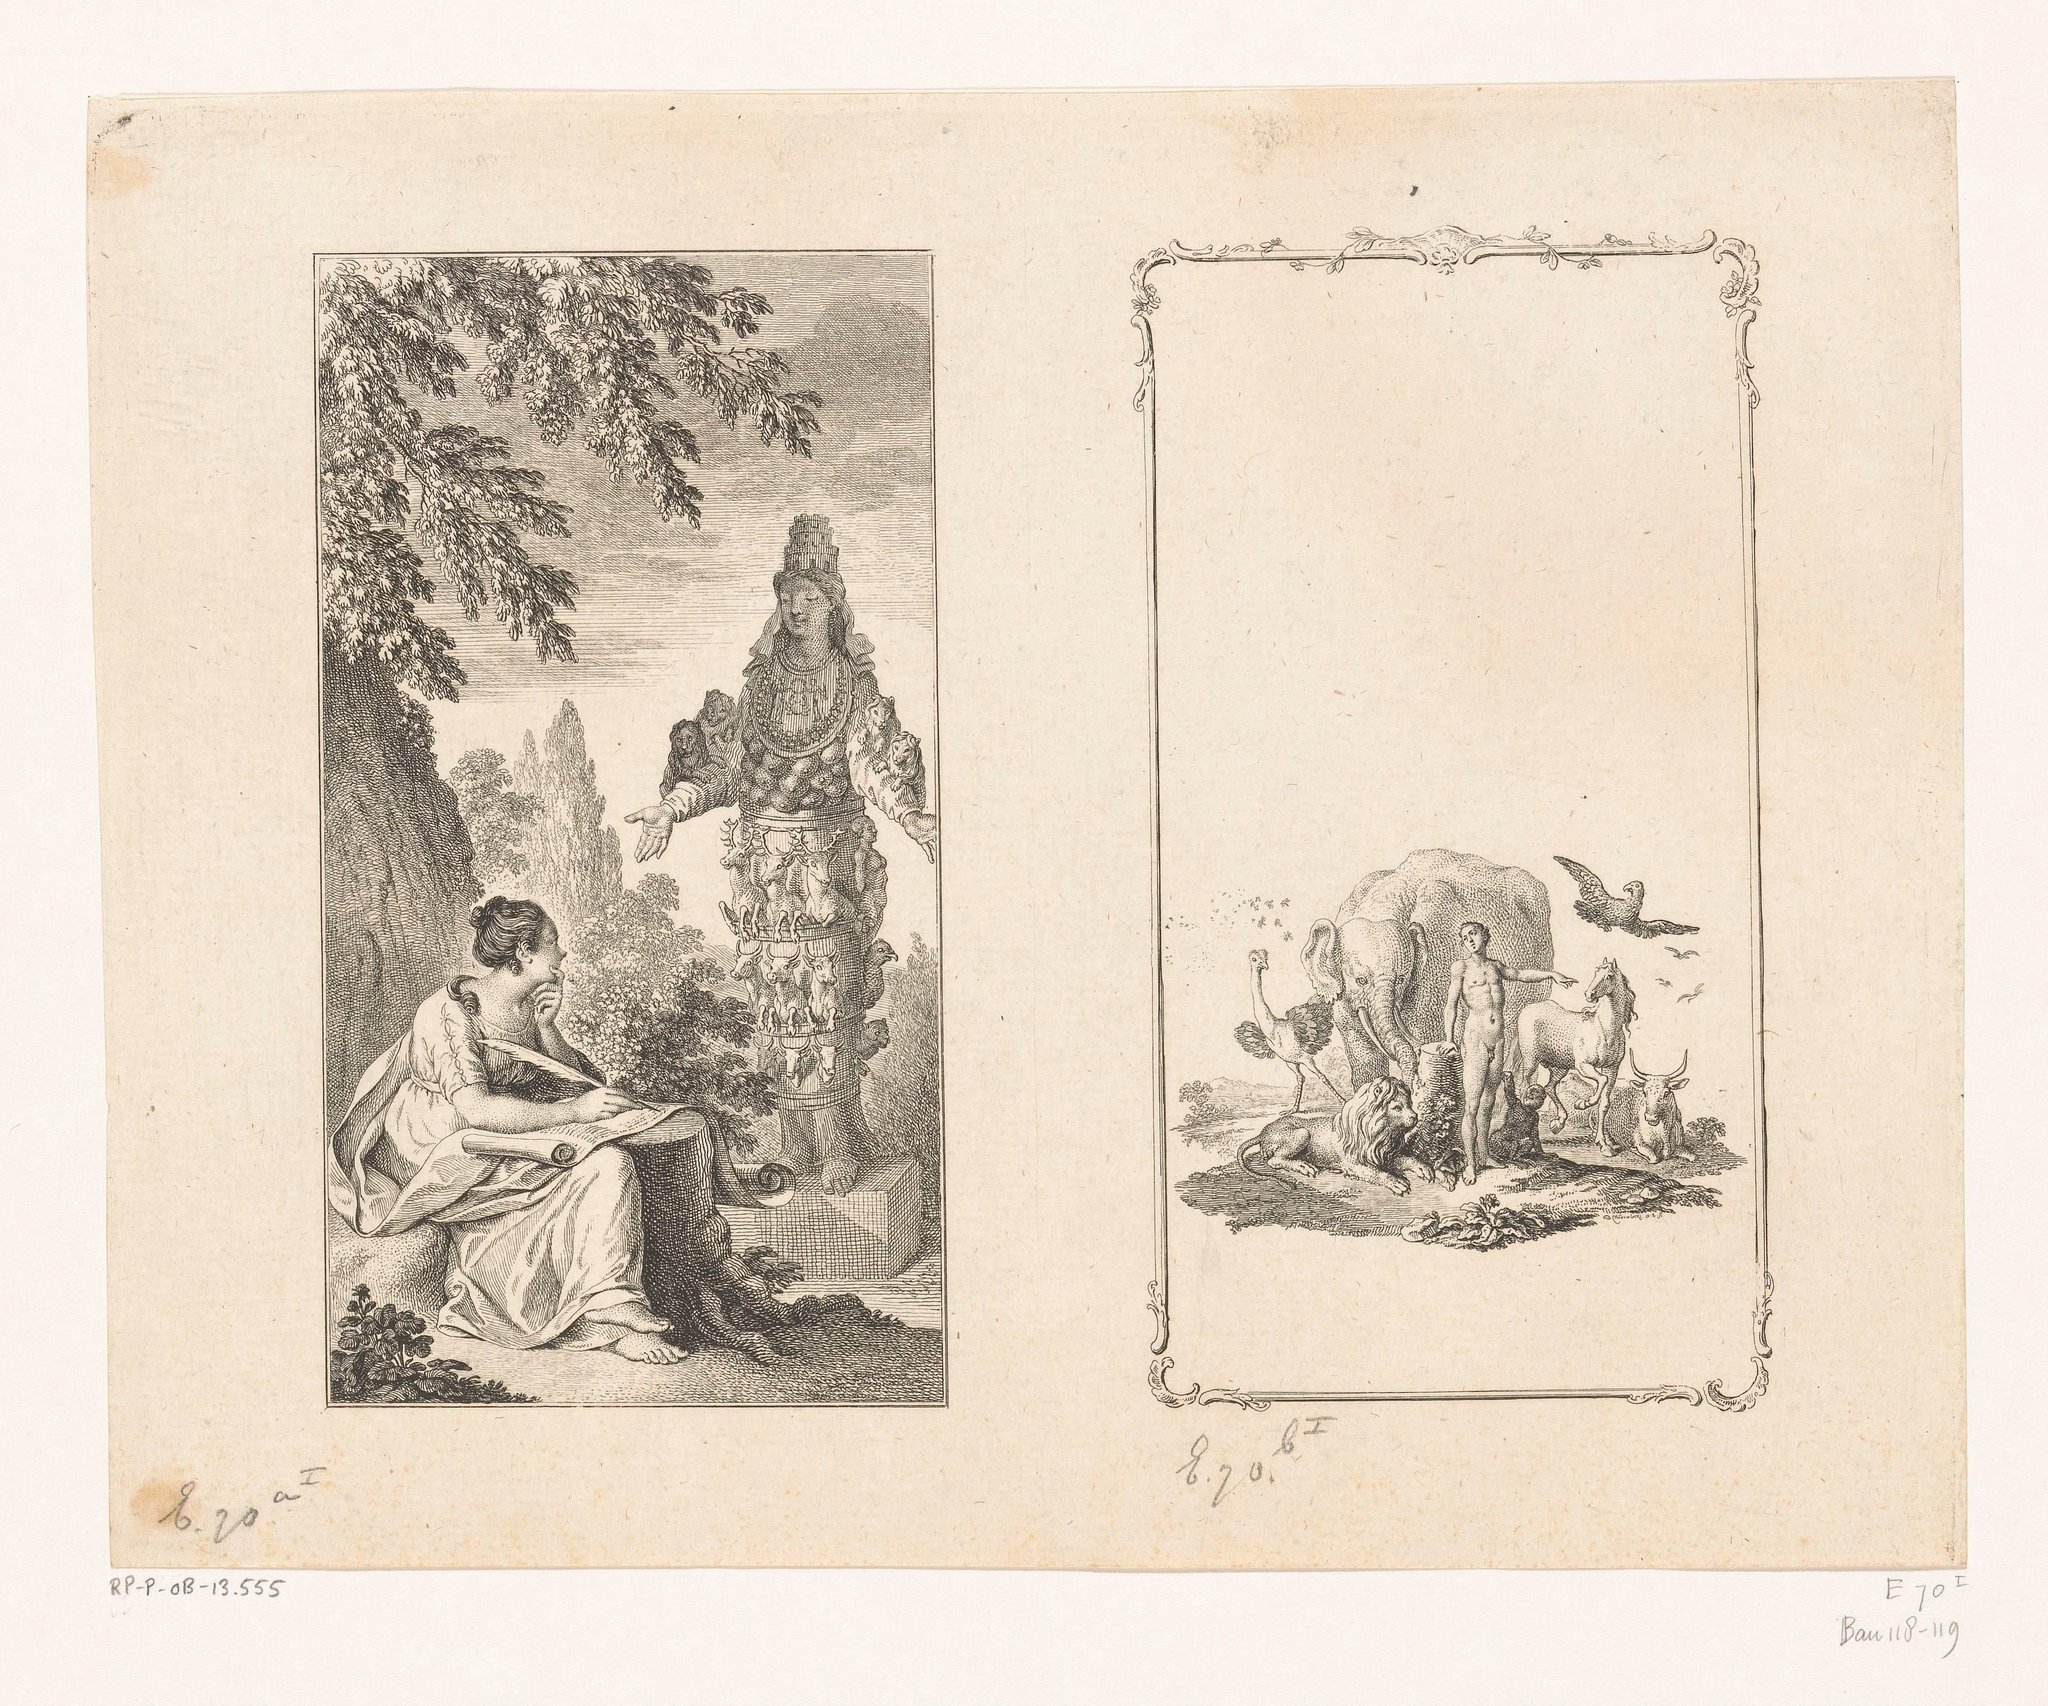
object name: print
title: Historia en Natura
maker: daniel nikolaus chodowiecki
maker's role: draughtsman, print maker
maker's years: 1726-1801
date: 1771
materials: paper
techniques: etching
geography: berlin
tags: georges-louis leclerc de buffon (graaf), 'natura' (allegorical figure or scene; or as diana of ephesus, with many breasts); 'natura' (ripa), walker and runner birds: ostrich, 'historia'; 'historia' (ripa), beasts of prey, predatory animals: lion, male sex; man, trunked animals: elephant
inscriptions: collector's mark: Lugt 240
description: Chodowiecki maakte deze voorstellingen voor een Duitse uitgave van Buffon's 'Histoire naturelle'. Een latere staat is gebruikt in: Herrn von Büffon's allgemeine Naturgeschichte. Eine freye, mit einigen Zusätzen vermehrte übersetzung nach der neuesten franz. Ausgabe von 1769. Berlijn: Joachim Pauli, 1771, dl. 1.